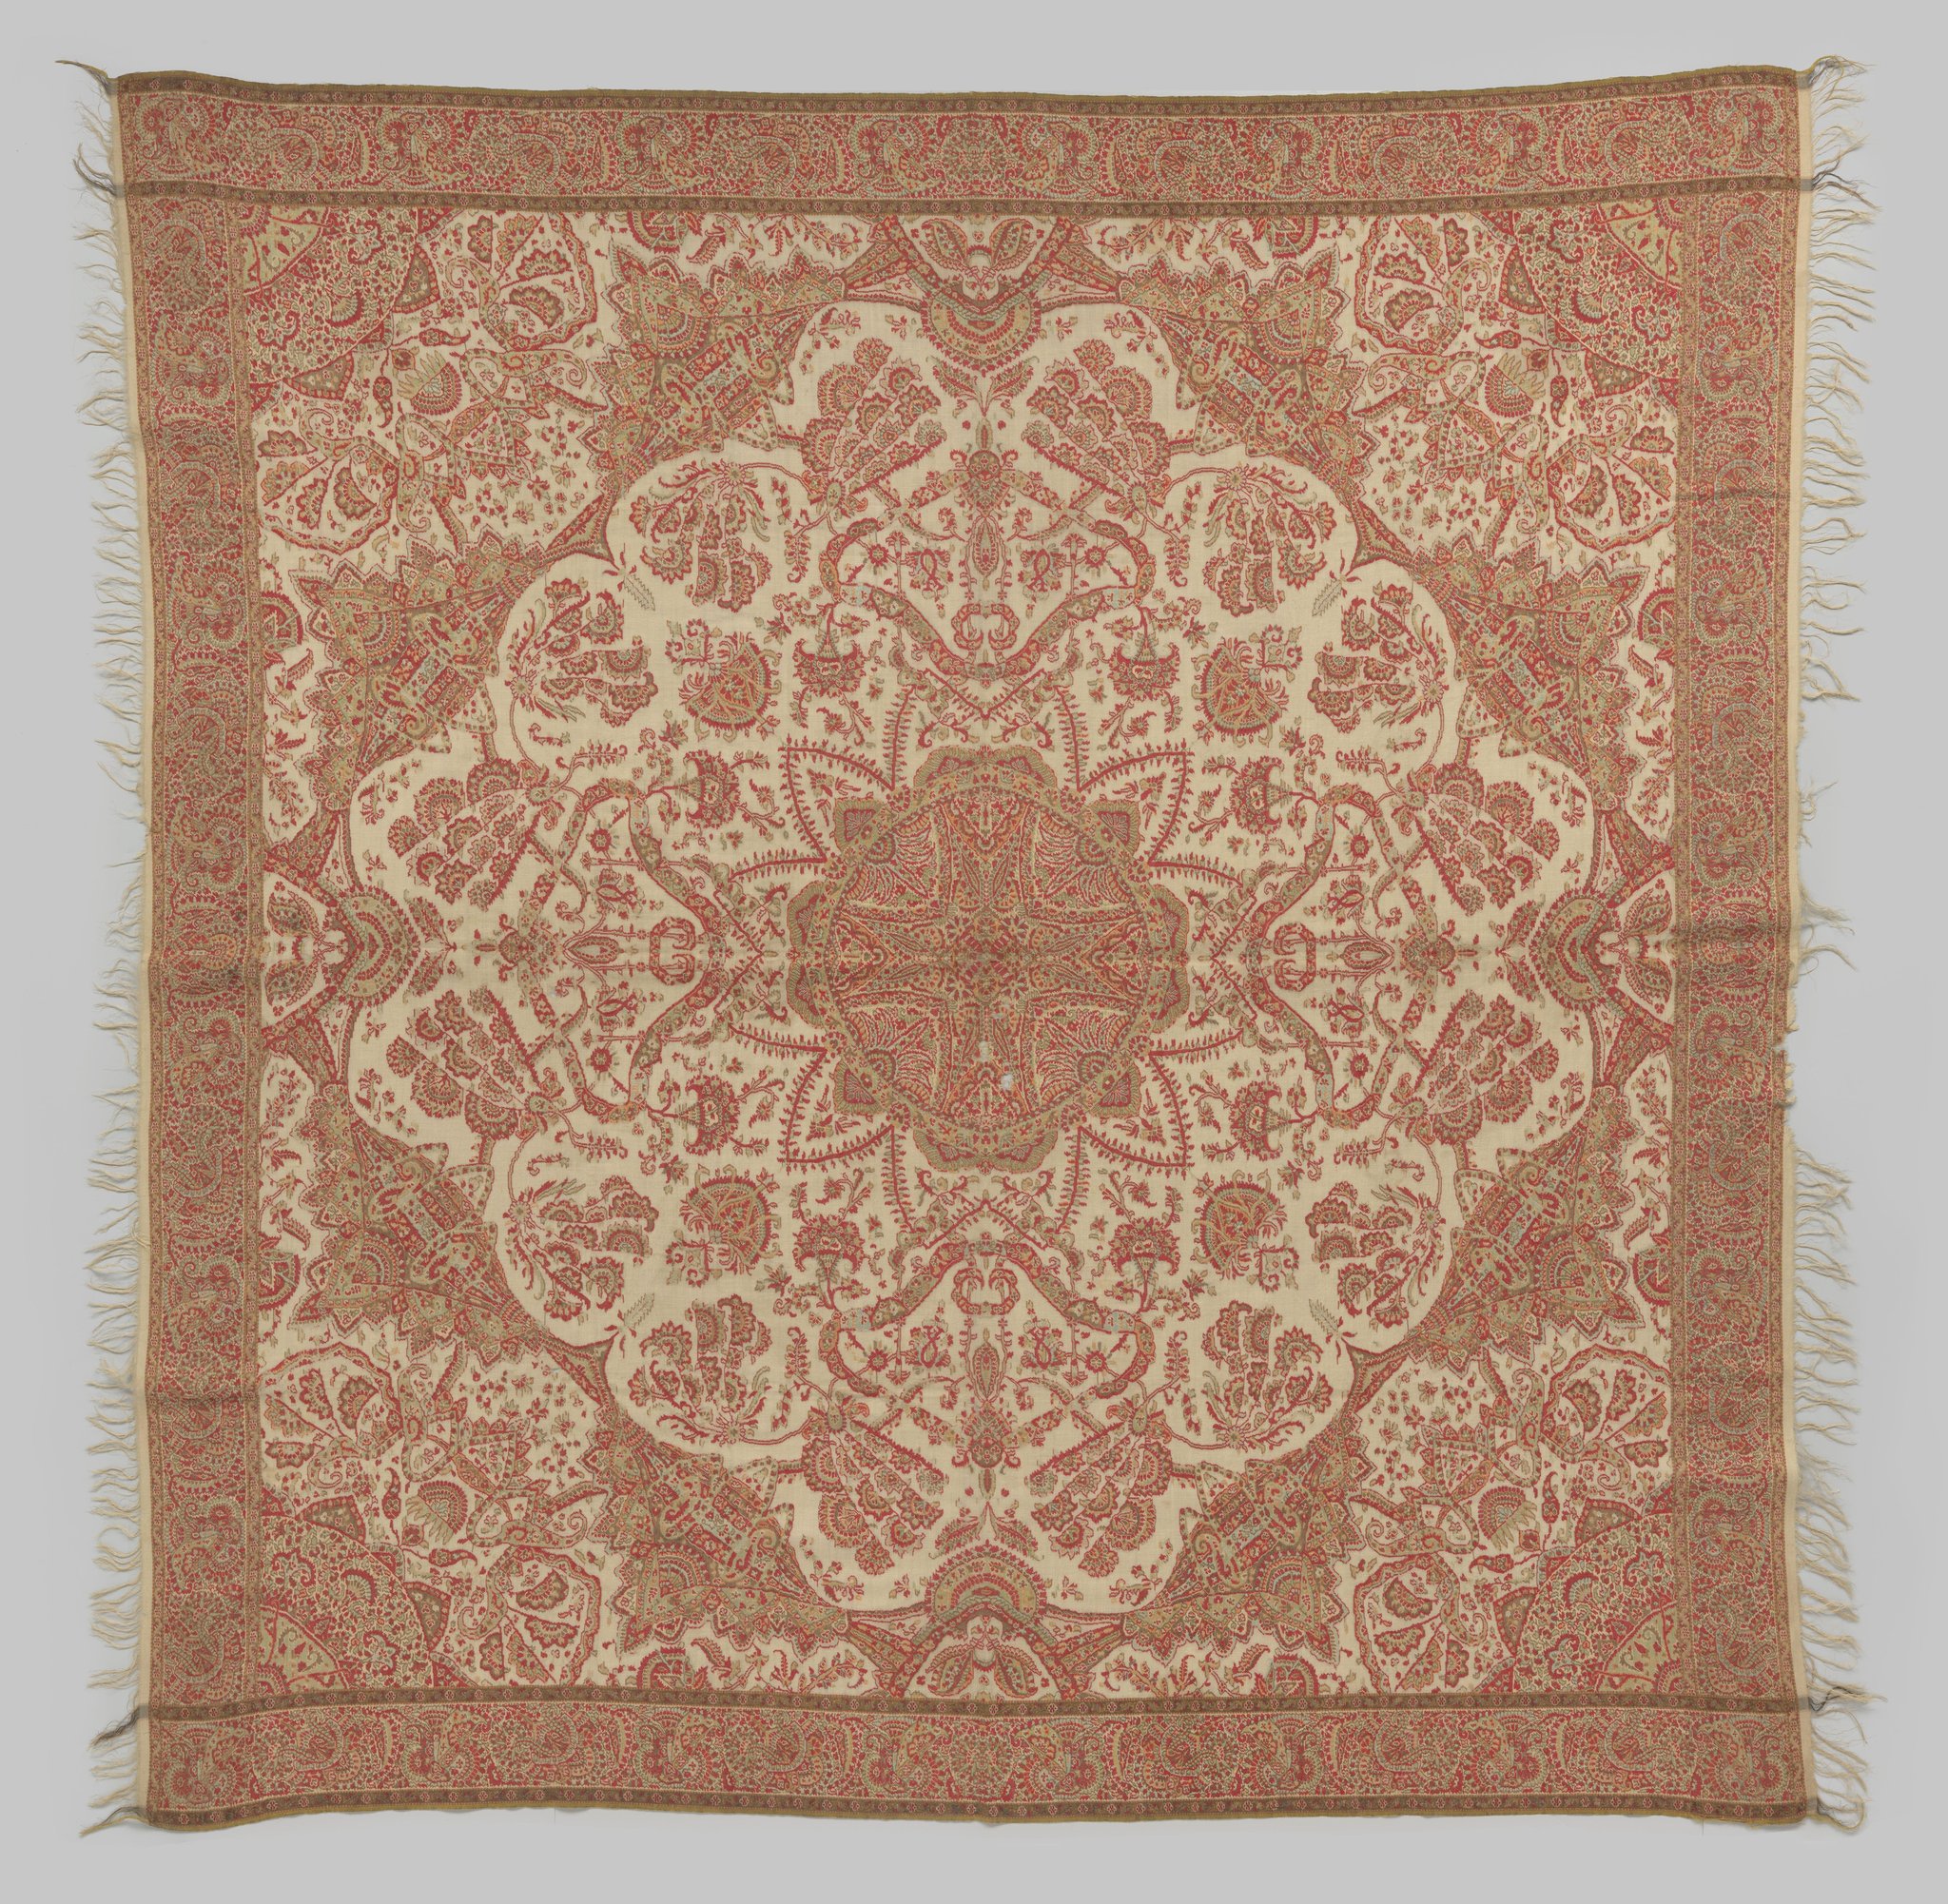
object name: scarf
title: Vierkante sjaal met middenin een twaalfpuntig roodgroene hartrozet waaromheen een vol patroon van bloem- en bladmotieven tegen een naturel fond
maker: Anonymous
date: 1820-1830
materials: silk, wool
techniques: weave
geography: norwich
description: Palmensjaal, geweven van wol en zijde, tegen een wit fond een ovall-over patroon en in de rand een dichtgesloten patroon in rode en grijsgroene schetslijnen en lichtgroene, lichtblauwe en oranje vullingen. Het middenpatroon is een symmetrisch patrron om de kruisassen. Het twaalfpuntige hartrozet heeft open bloembladeren en een gesloten rond medaillon met vier grote naar binnen gerichte spitsboogbladeren. De gelobde rand sluit tegen de buitenrand met acolades die acht spitsen vormen, gevuld met rugbybal-vormige ovale medaillons. Op de tussenliggende cirkelboog staan vier luchtige acolades waaromheen fijne ranken met waaiervormige bladeren. In de hoeken kwartsterrozetten en luchtige W-vormige acolades en fijne ranken. De zijrand is oversneden door de dwarsranden met donkergroene zoomlijsten, welke in blauwe franjes uitlopen. Gesloten bloempatroon in dezelfde kleur.